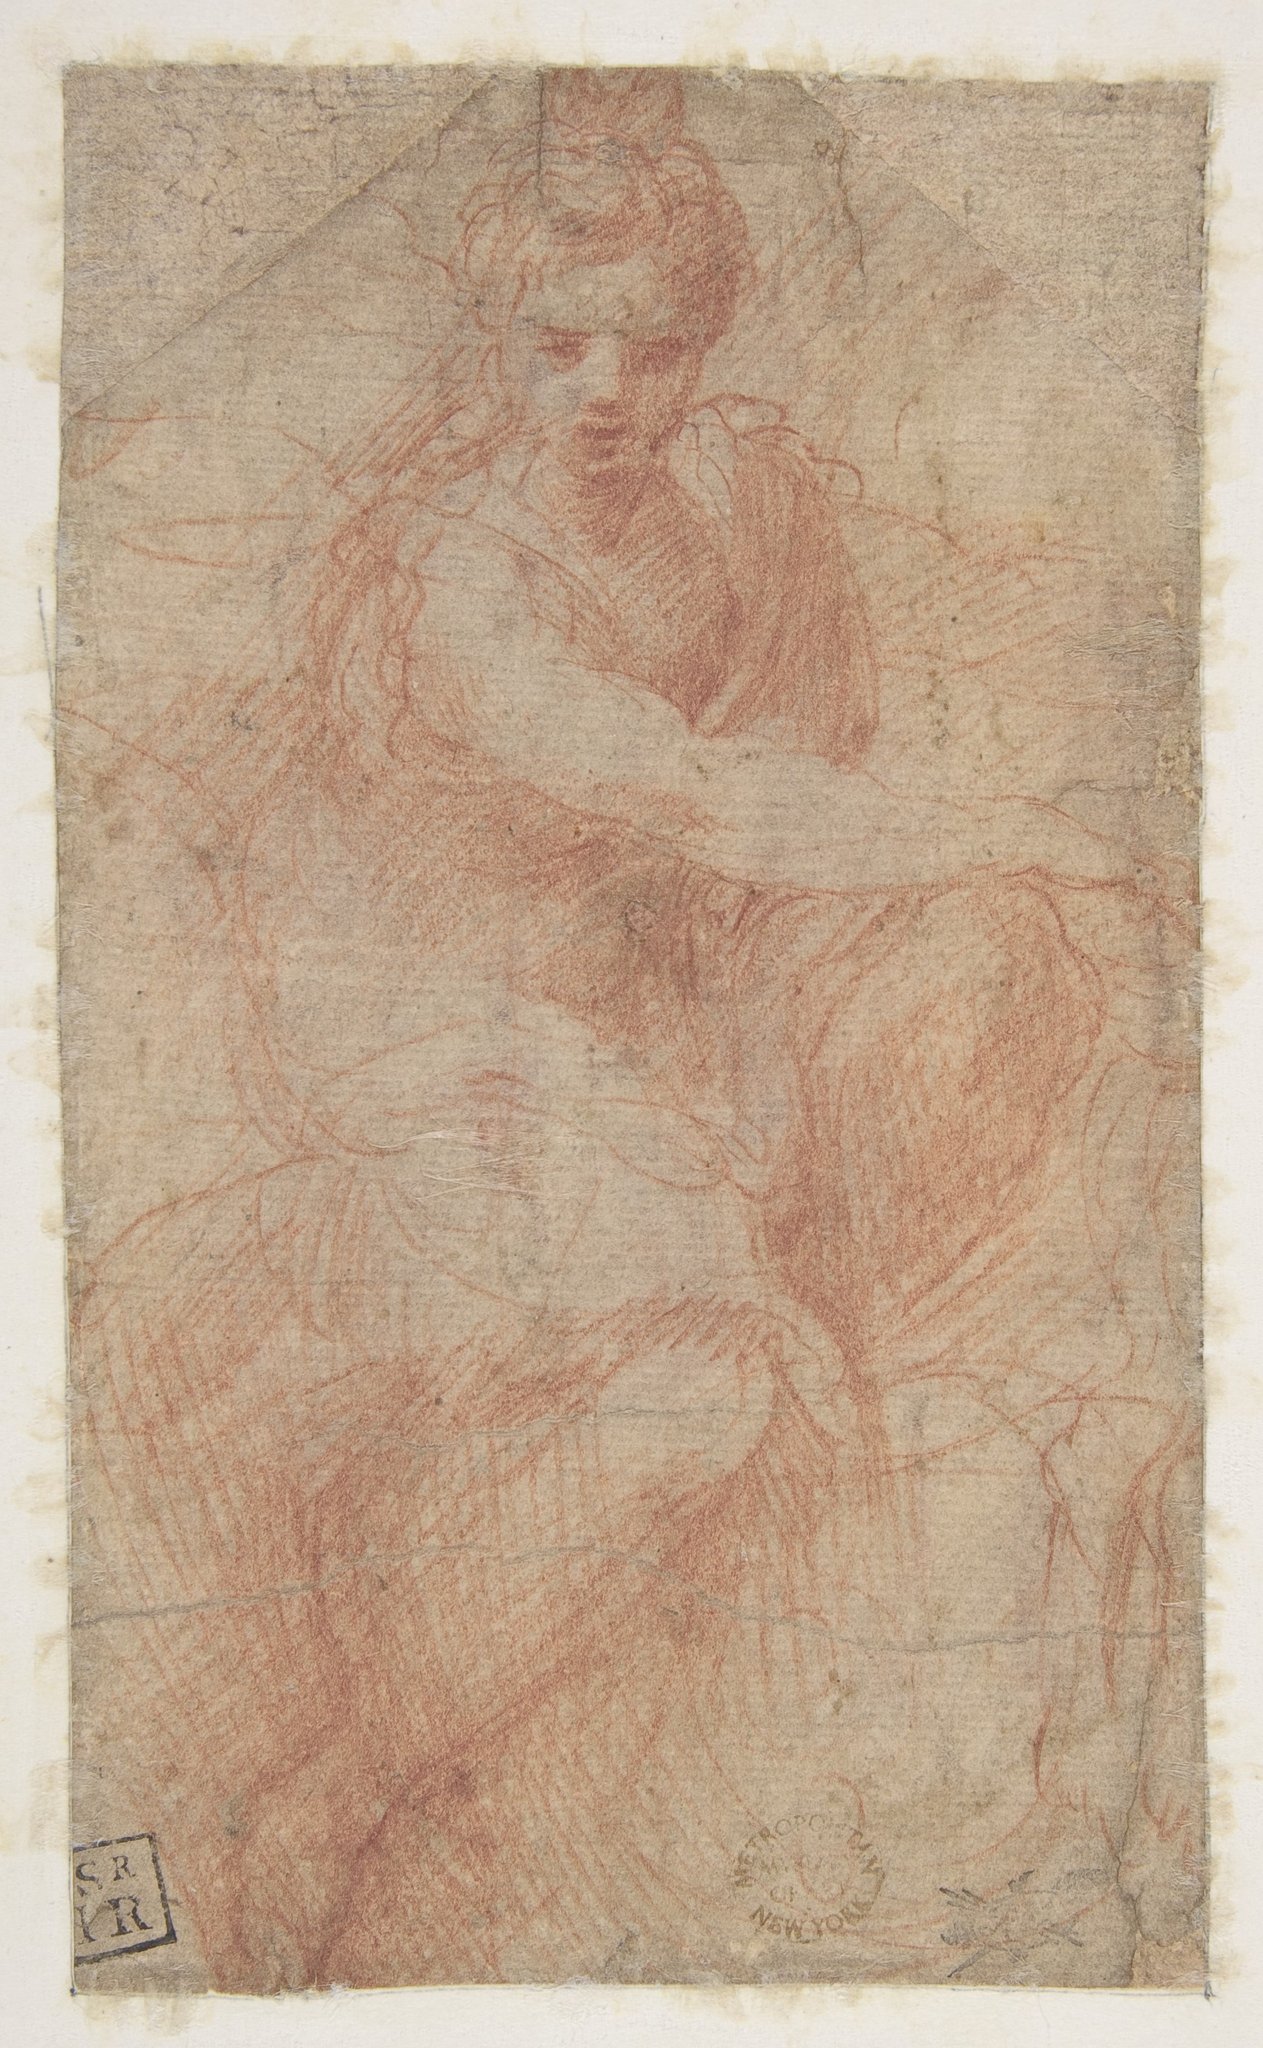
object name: drawing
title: Seated Goddess Diana (recto); Studies of a Nude Male Torso Seen from the Rear, and a leg (verso)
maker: parmigianino (girolamo francesco maria mazzola)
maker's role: artist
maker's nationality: italian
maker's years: 1503-1540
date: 1522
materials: chalk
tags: male nudes,diana